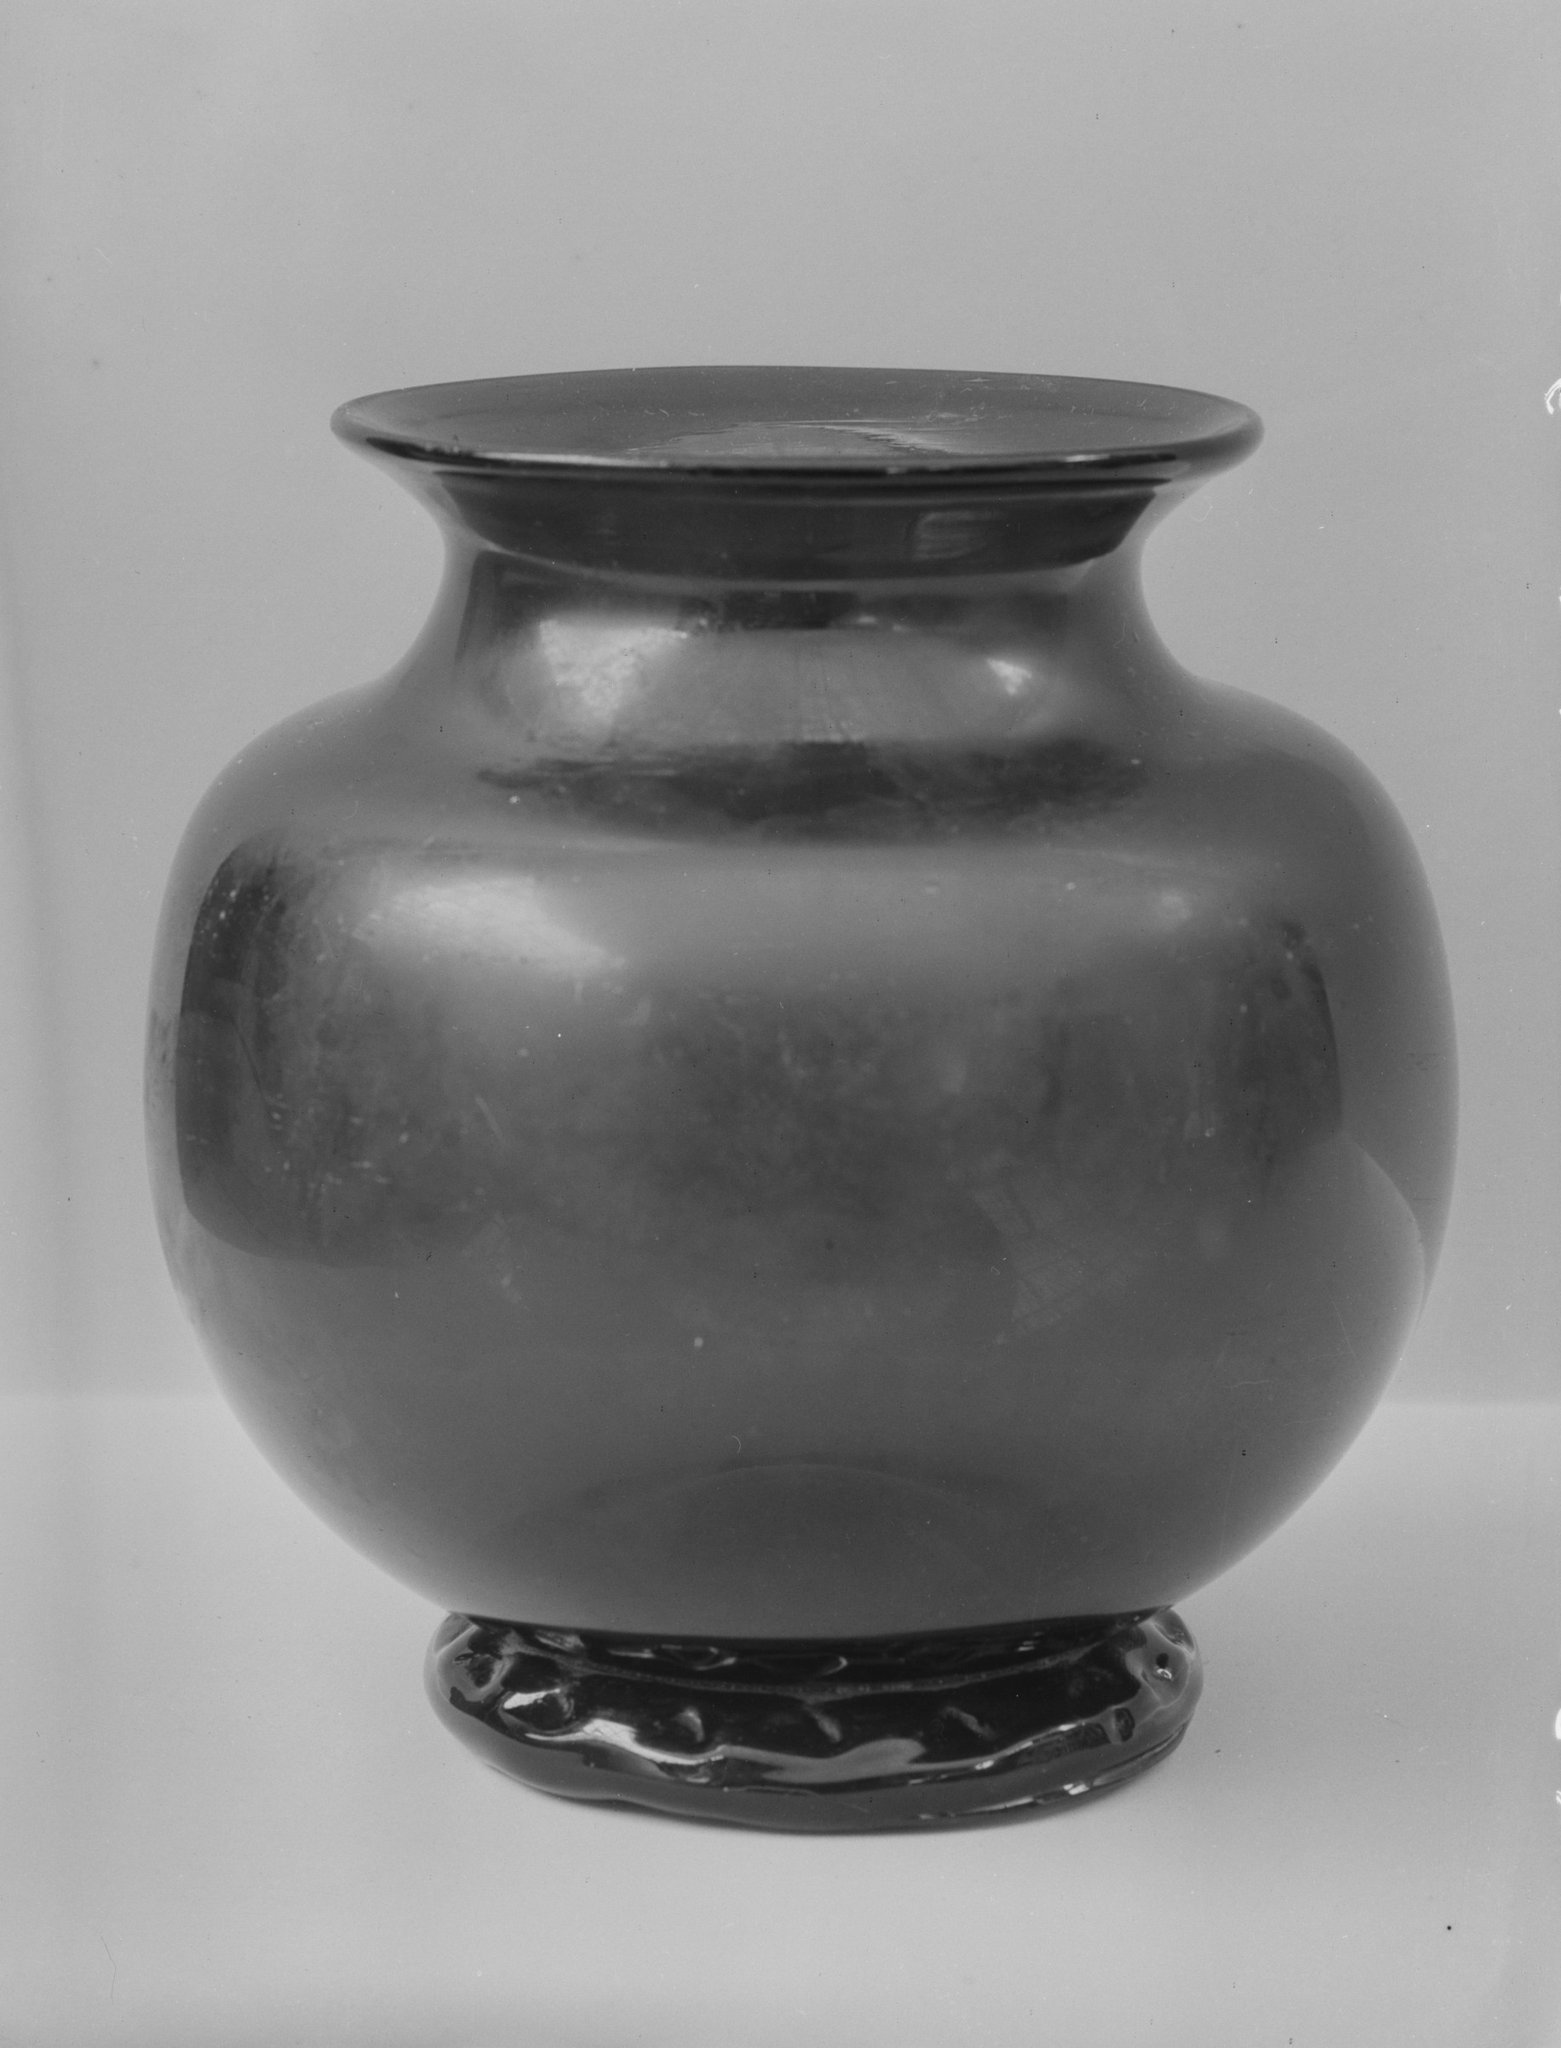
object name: bowl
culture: american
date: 1830-1850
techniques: glassblowing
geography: united states